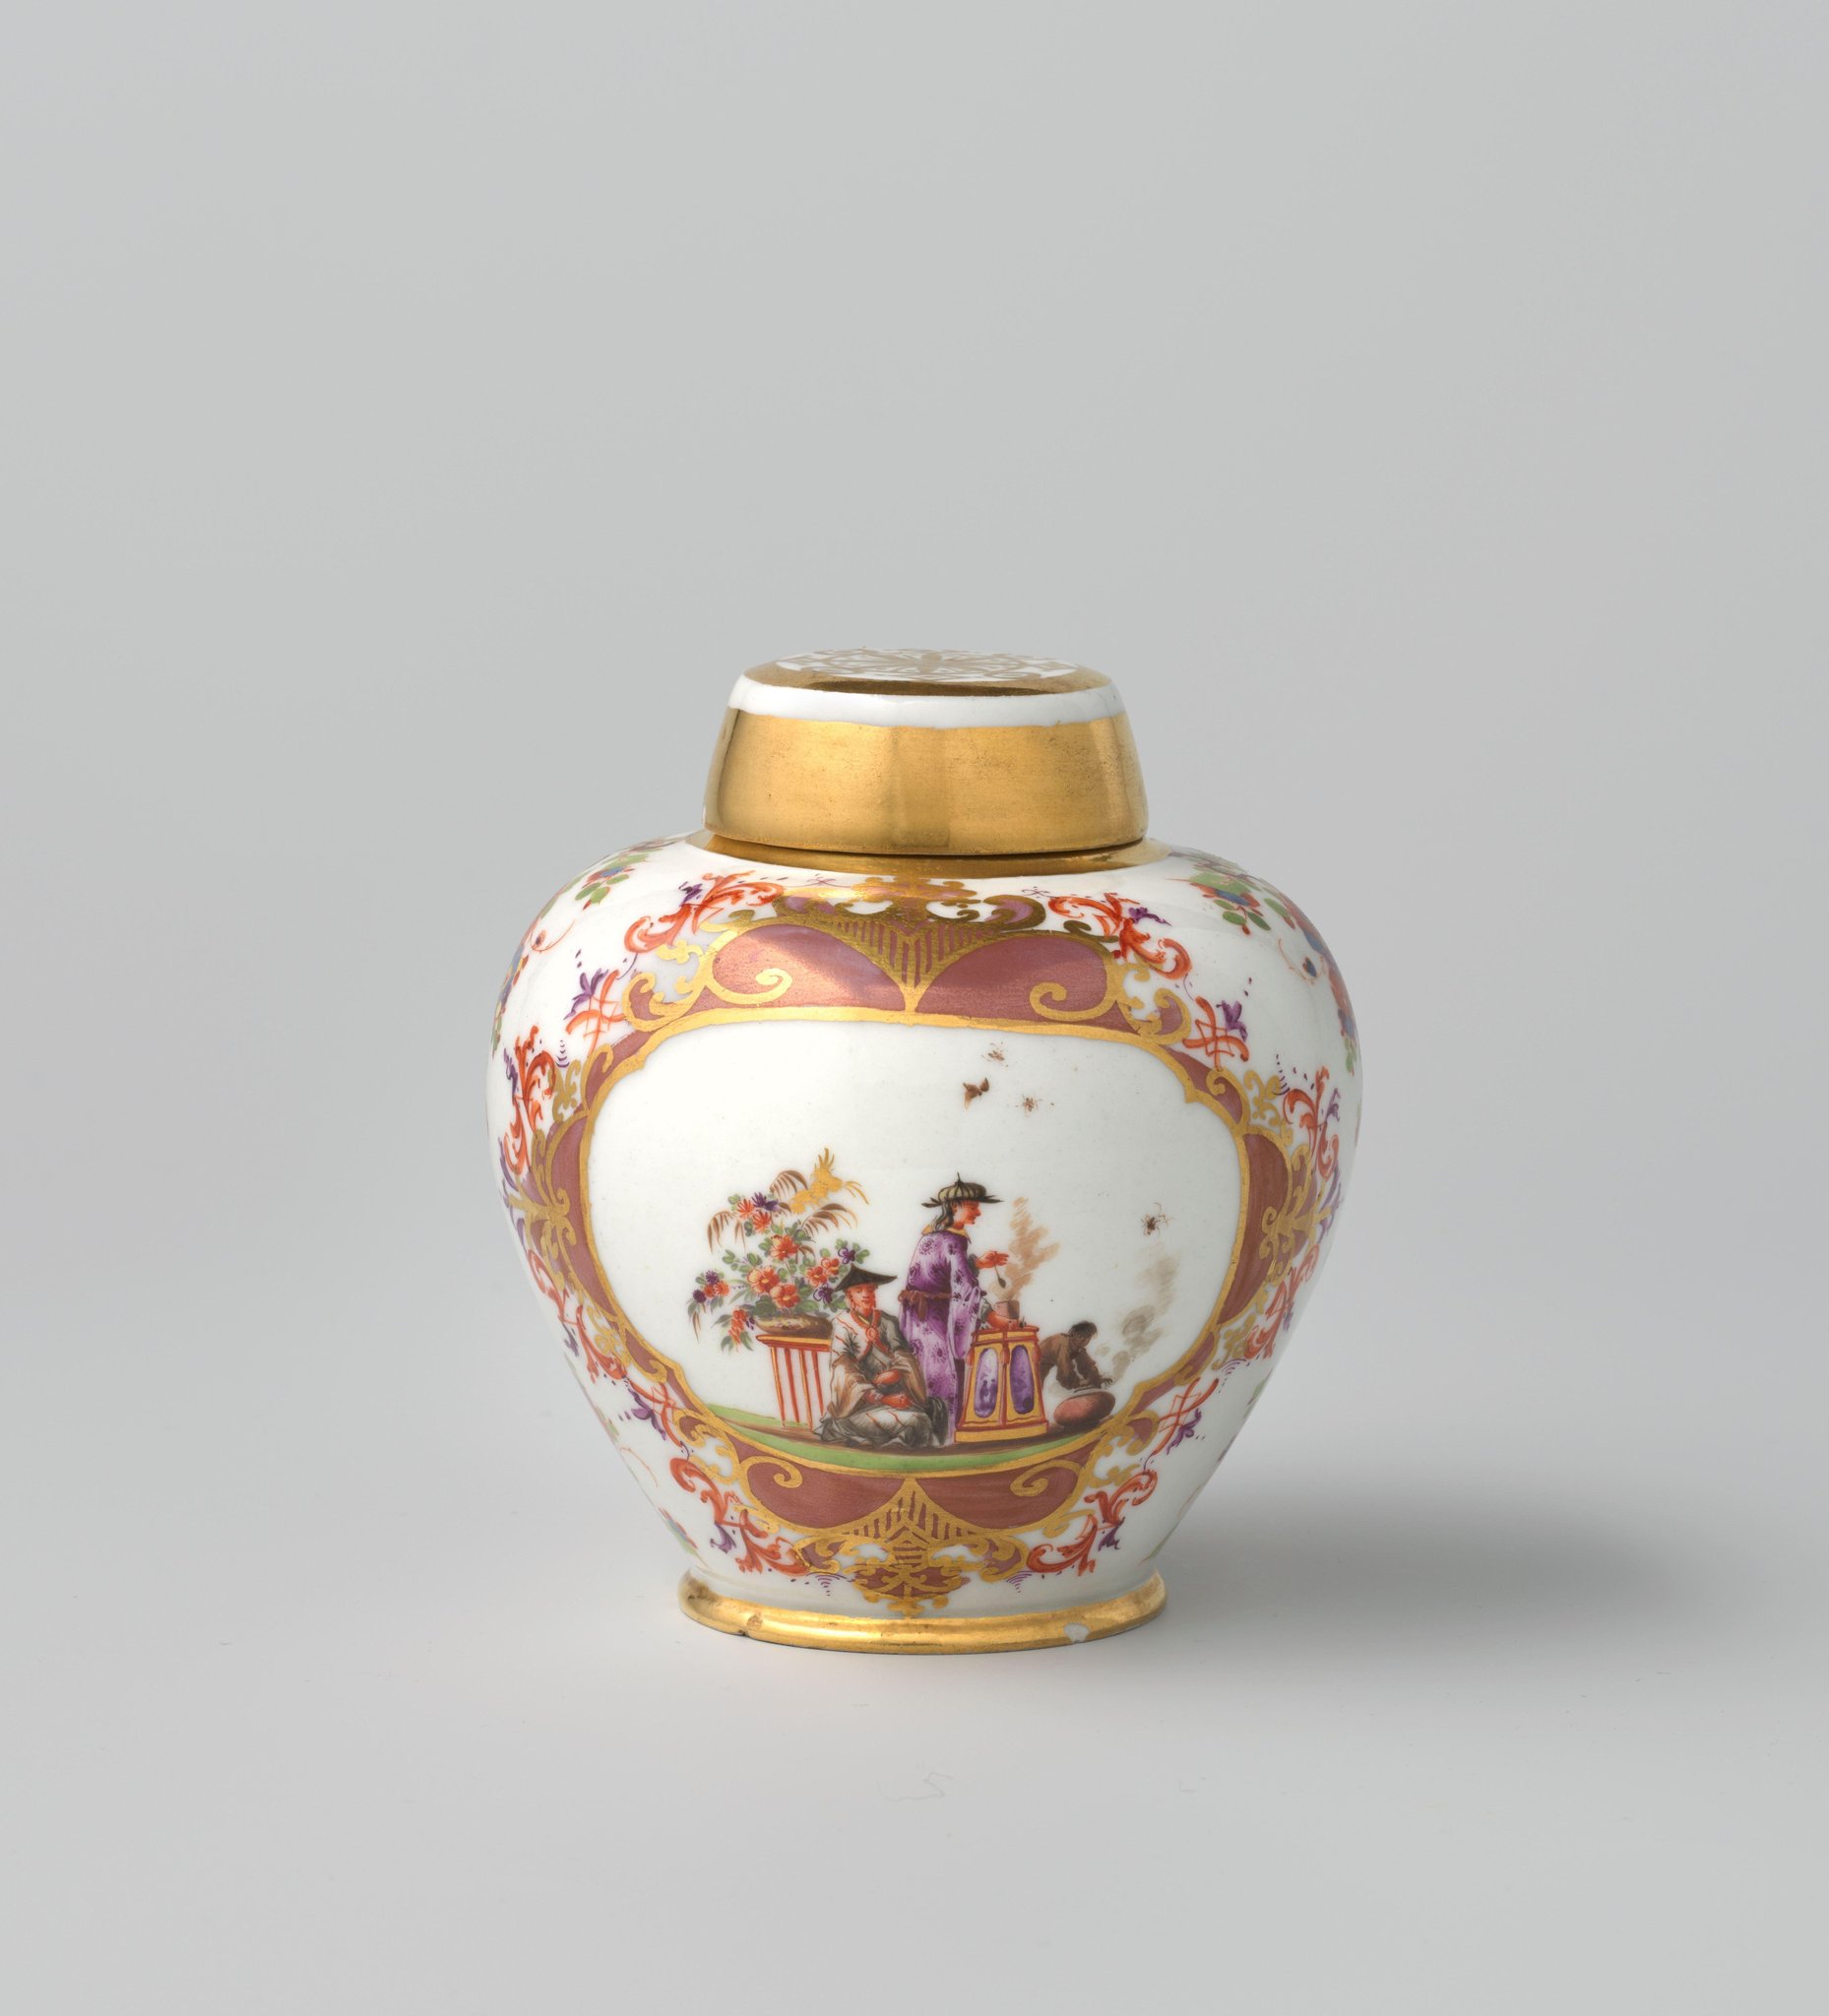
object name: lid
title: Theebus met deksel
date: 1725-1730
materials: porcelain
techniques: gilding, painted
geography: meissen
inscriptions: number: ‘20’, number: ‘164.’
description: Dit object is van 1953 tot en met 2019 vanuit de Rijkscollectie ondergebracht geweest bij Museum Boijmans van Beuningen in Rotterdam. Een theekop en schotel uit dit servies zat in de collectie Anrhold, verworven door Lisa en Heinrich Arnhold in 1927 van M. Salomon in Dresden, geïllustreerd in Cassidy-Geiger, 2008, p. 302, cat. nr. 76 (veiling catalogus, Sotheby’s New York, 14 september 2021, nr. 68, p. 186).